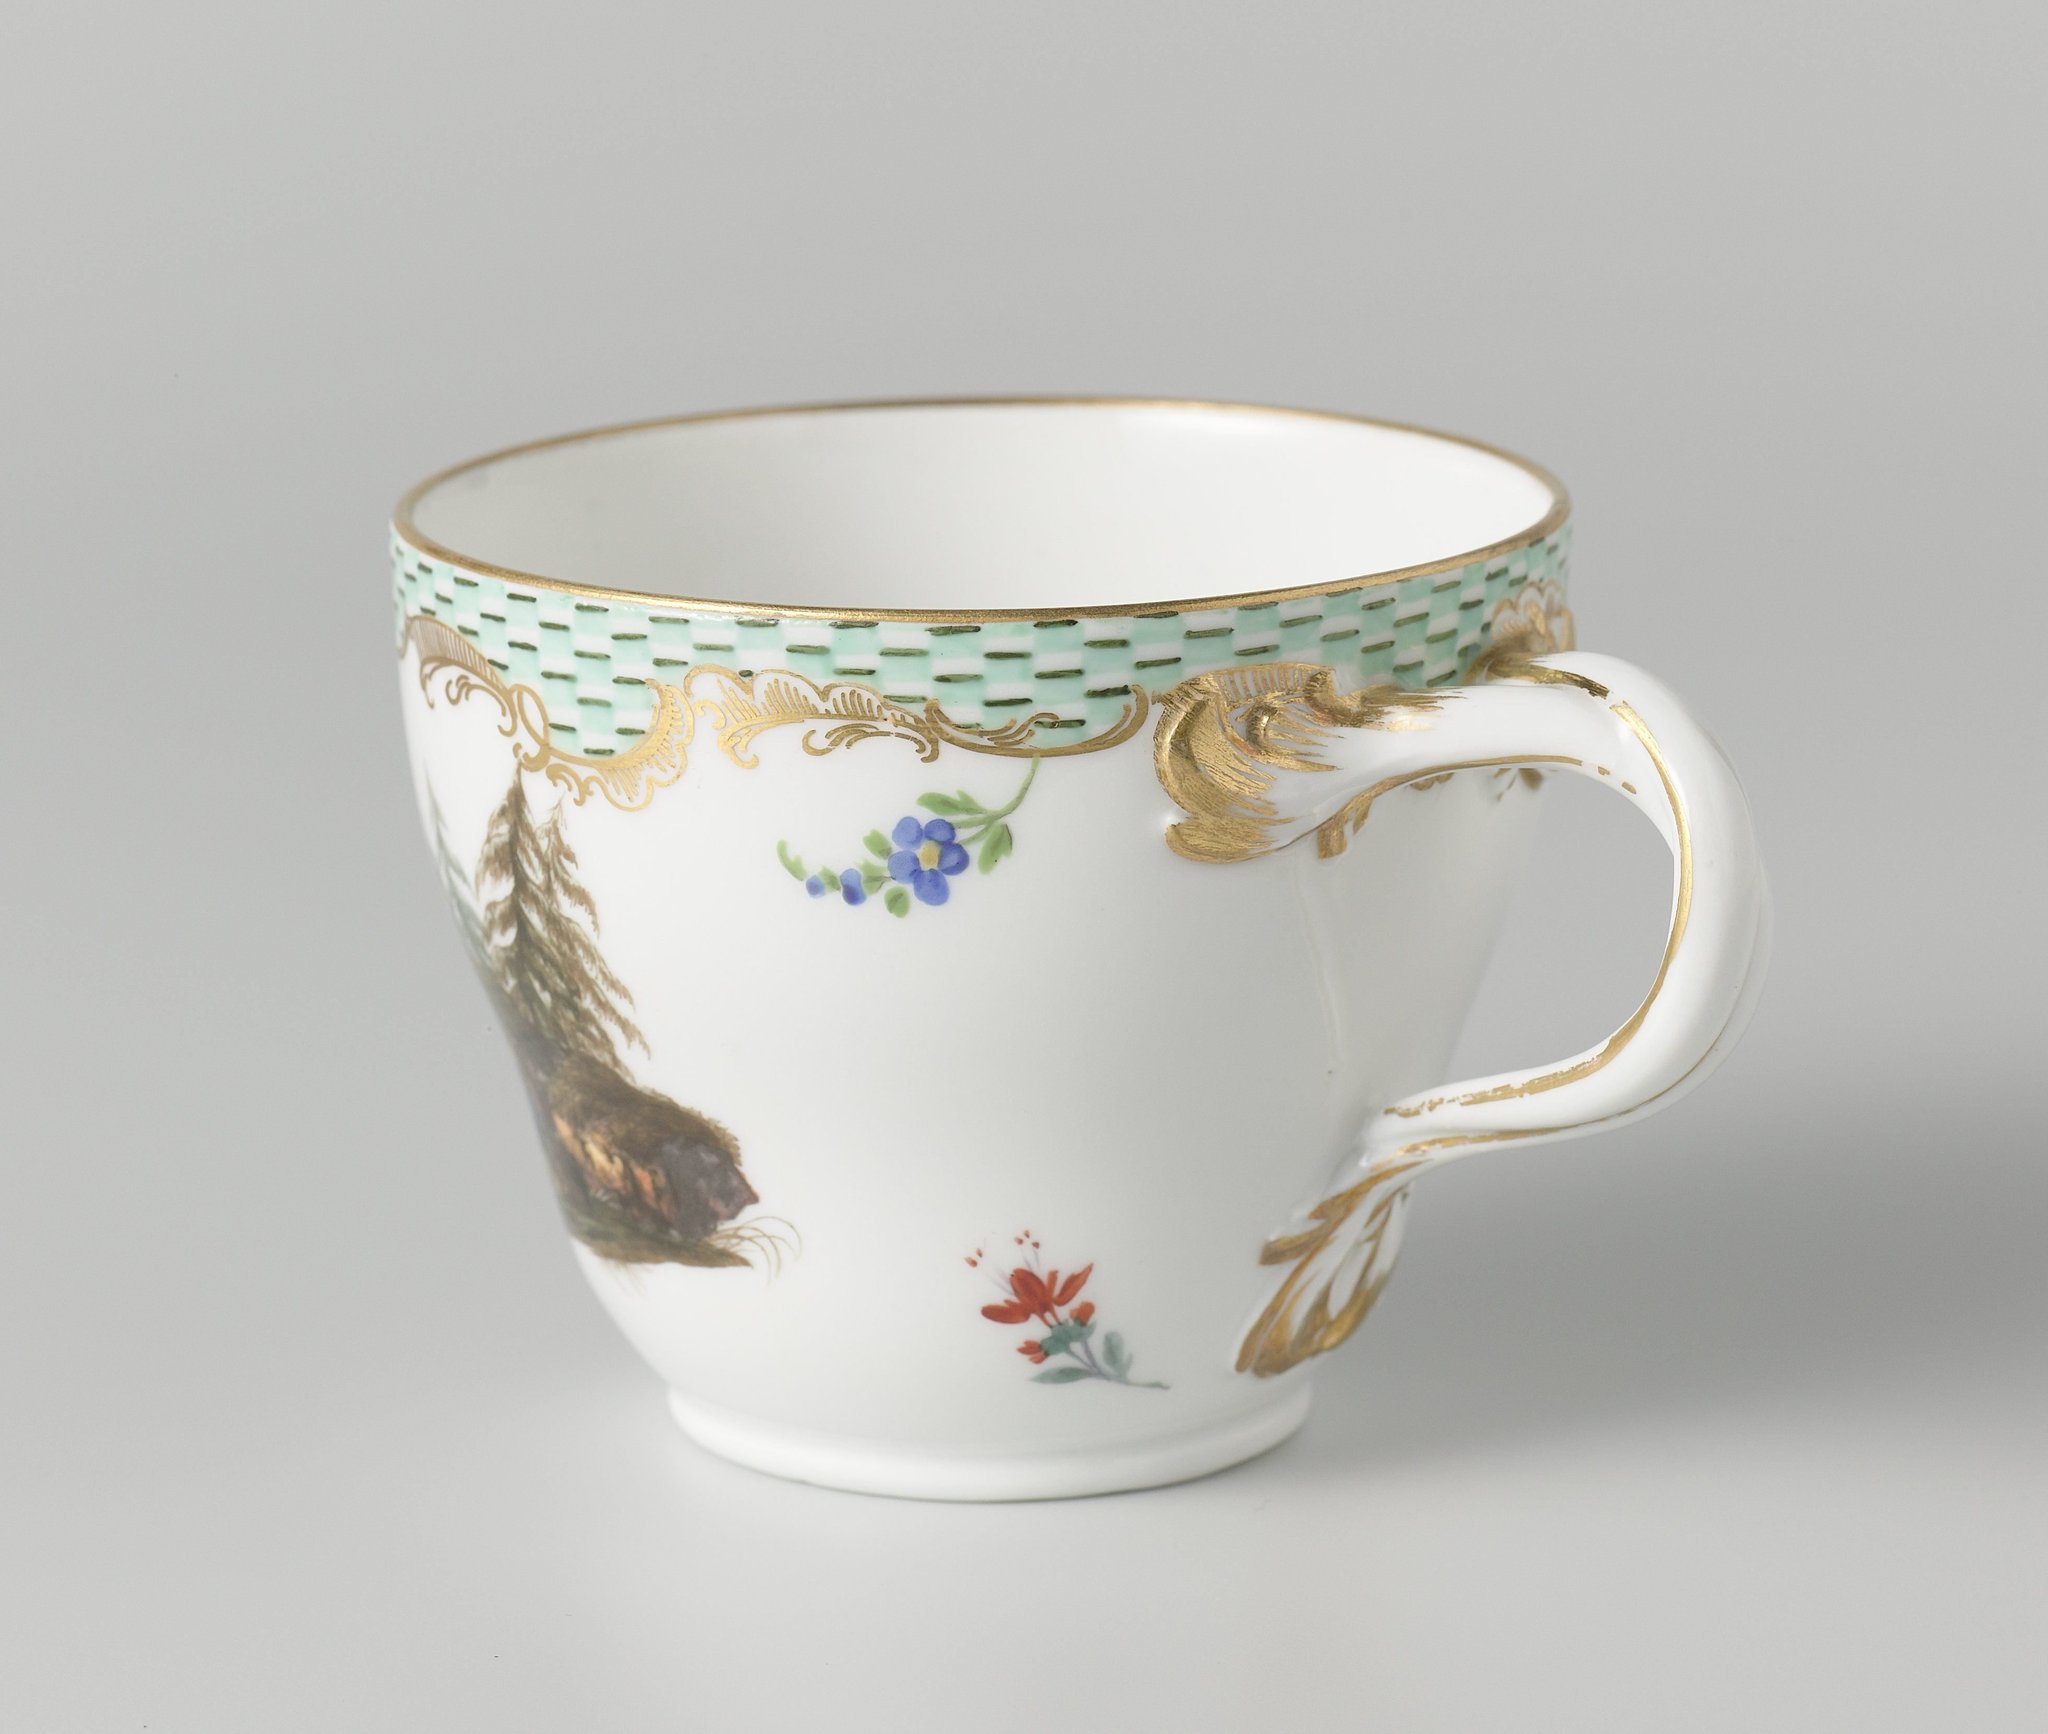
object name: pattipan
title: Kop, veelkleurig beschilderd met een landschap met figuren.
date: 1777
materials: porcelain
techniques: painted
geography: meissen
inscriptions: factory mark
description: Hoge kop met oor, van beschilderd porselein. De kop is beschilderd met landschappen waarin figuren en langs de rand een brede strook groen vlechtwerk. De kop is gemerkt.